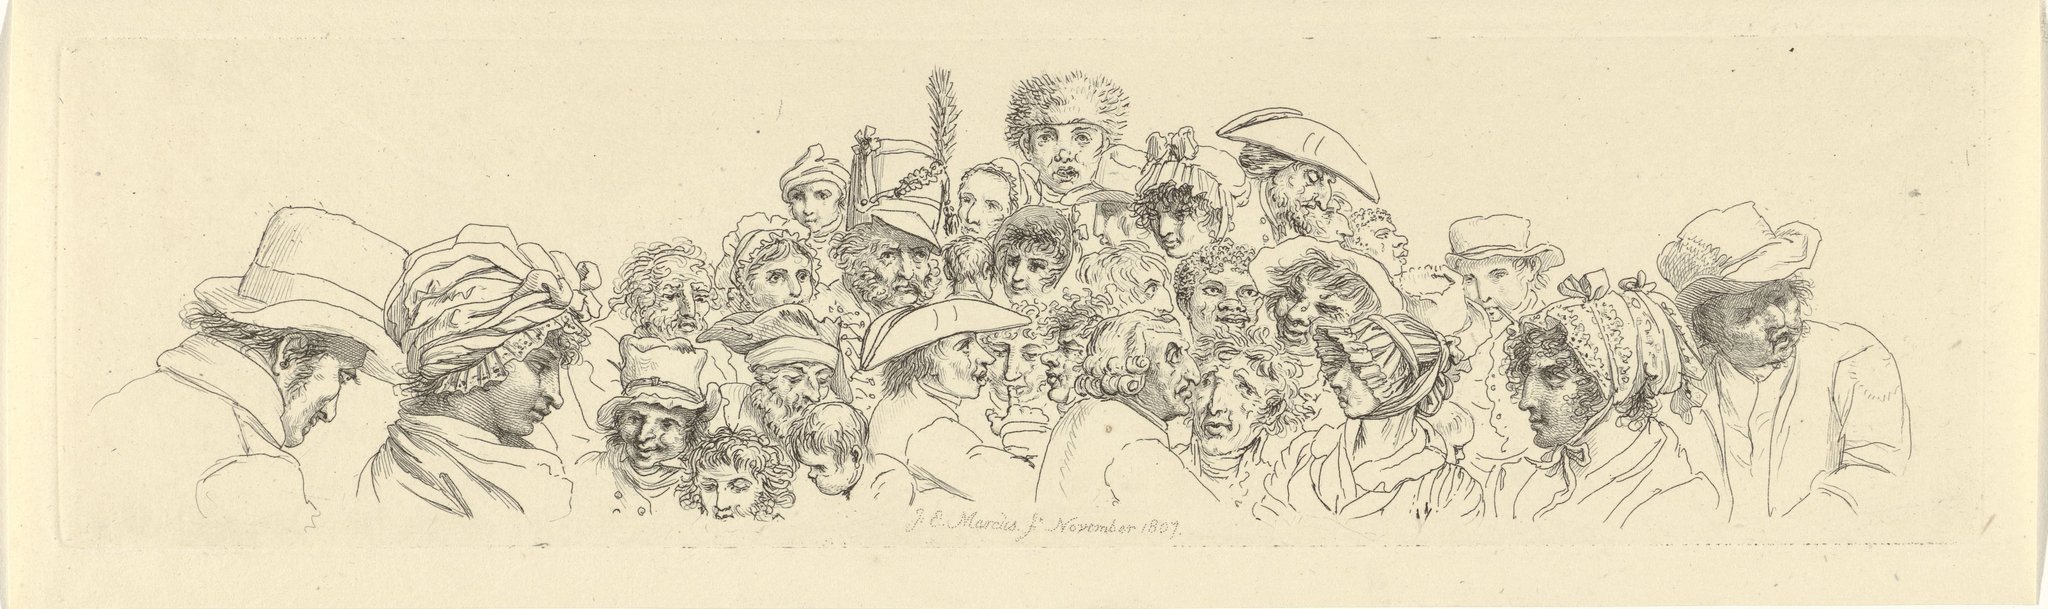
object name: print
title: Studie-prentwerk / Etudes gravées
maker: jacob ernst marcus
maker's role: draughtsman, print maker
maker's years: 1774-1826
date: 1807-1811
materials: paper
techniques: etching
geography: amsterdam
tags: head (human)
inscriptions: collector's mark: Lugt 2228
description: Serie voor het eerst uitgegeven door Jacob Ernst Marcus onder de titel Studiebeelden en Fragmenten. Amsterdam: ca.1816. Later heruitgegeven als: Studie-prentwerk/ Etudes gravées.